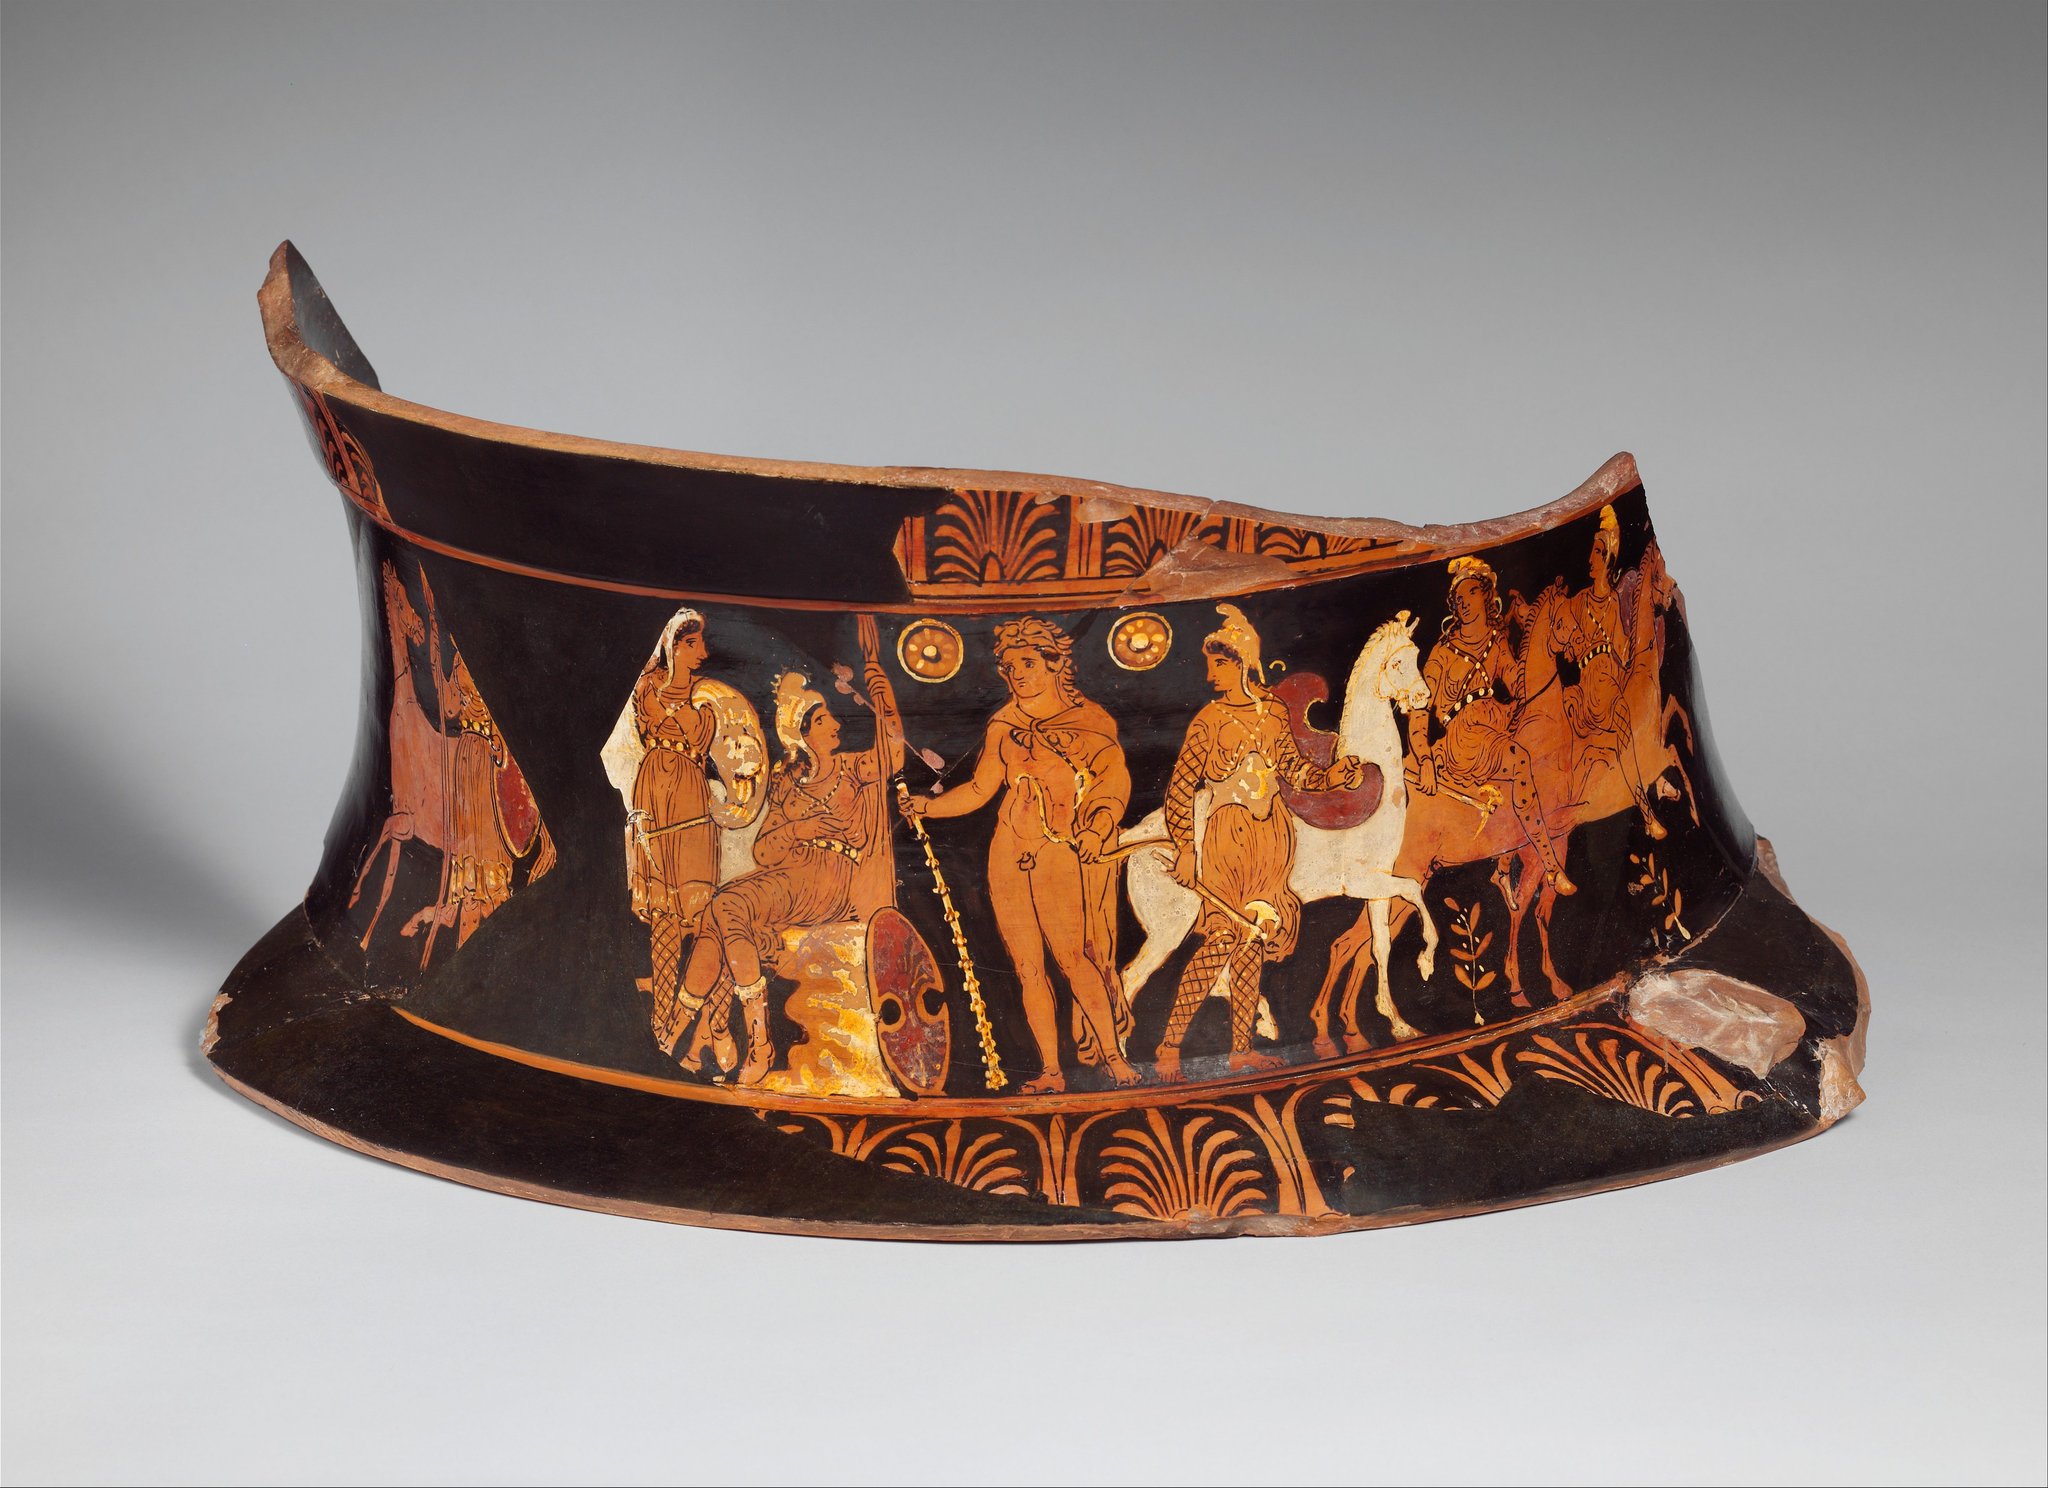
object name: volute krater fragment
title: Fragment of a terracotta volute-krater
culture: greek, south italian, apulian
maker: baltimore painter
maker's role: artist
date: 330-310 BCE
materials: terracotta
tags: male nudes,women,amazons,horses